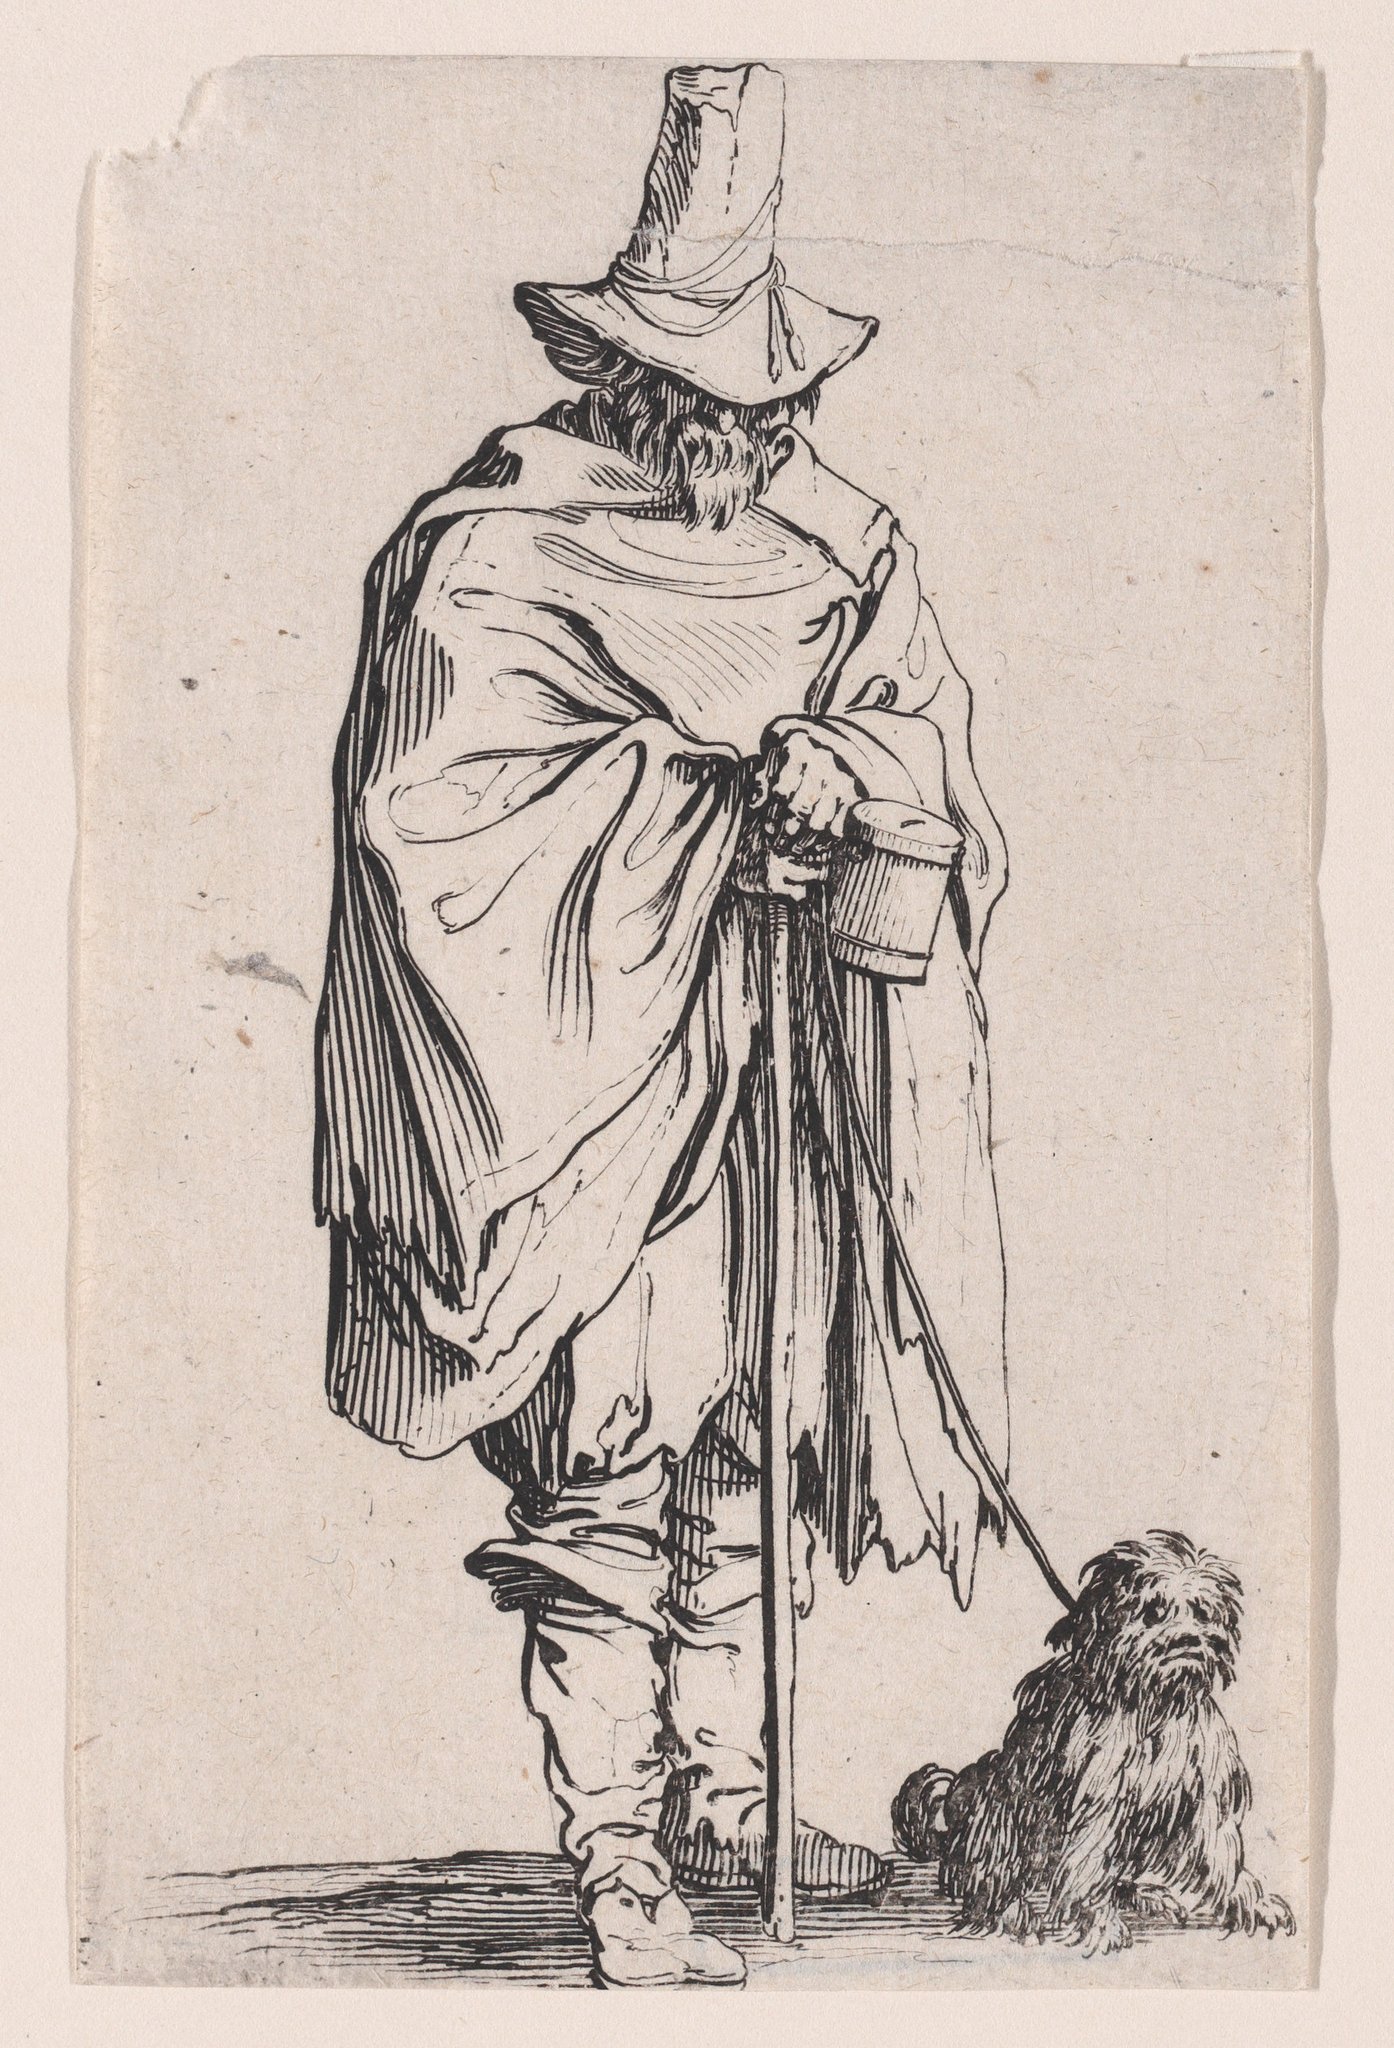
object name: print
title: L'Aveugle et son Chien (The Blind Man and his Dog), from "Les Gueux suite appelée aussi Les Mendiants, Les Baroni, ou Les Barons" (The Beggars, also called the Barons)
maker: jacques callot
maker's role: artist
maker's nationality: french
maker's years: 1592-1635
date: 1623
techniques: etching